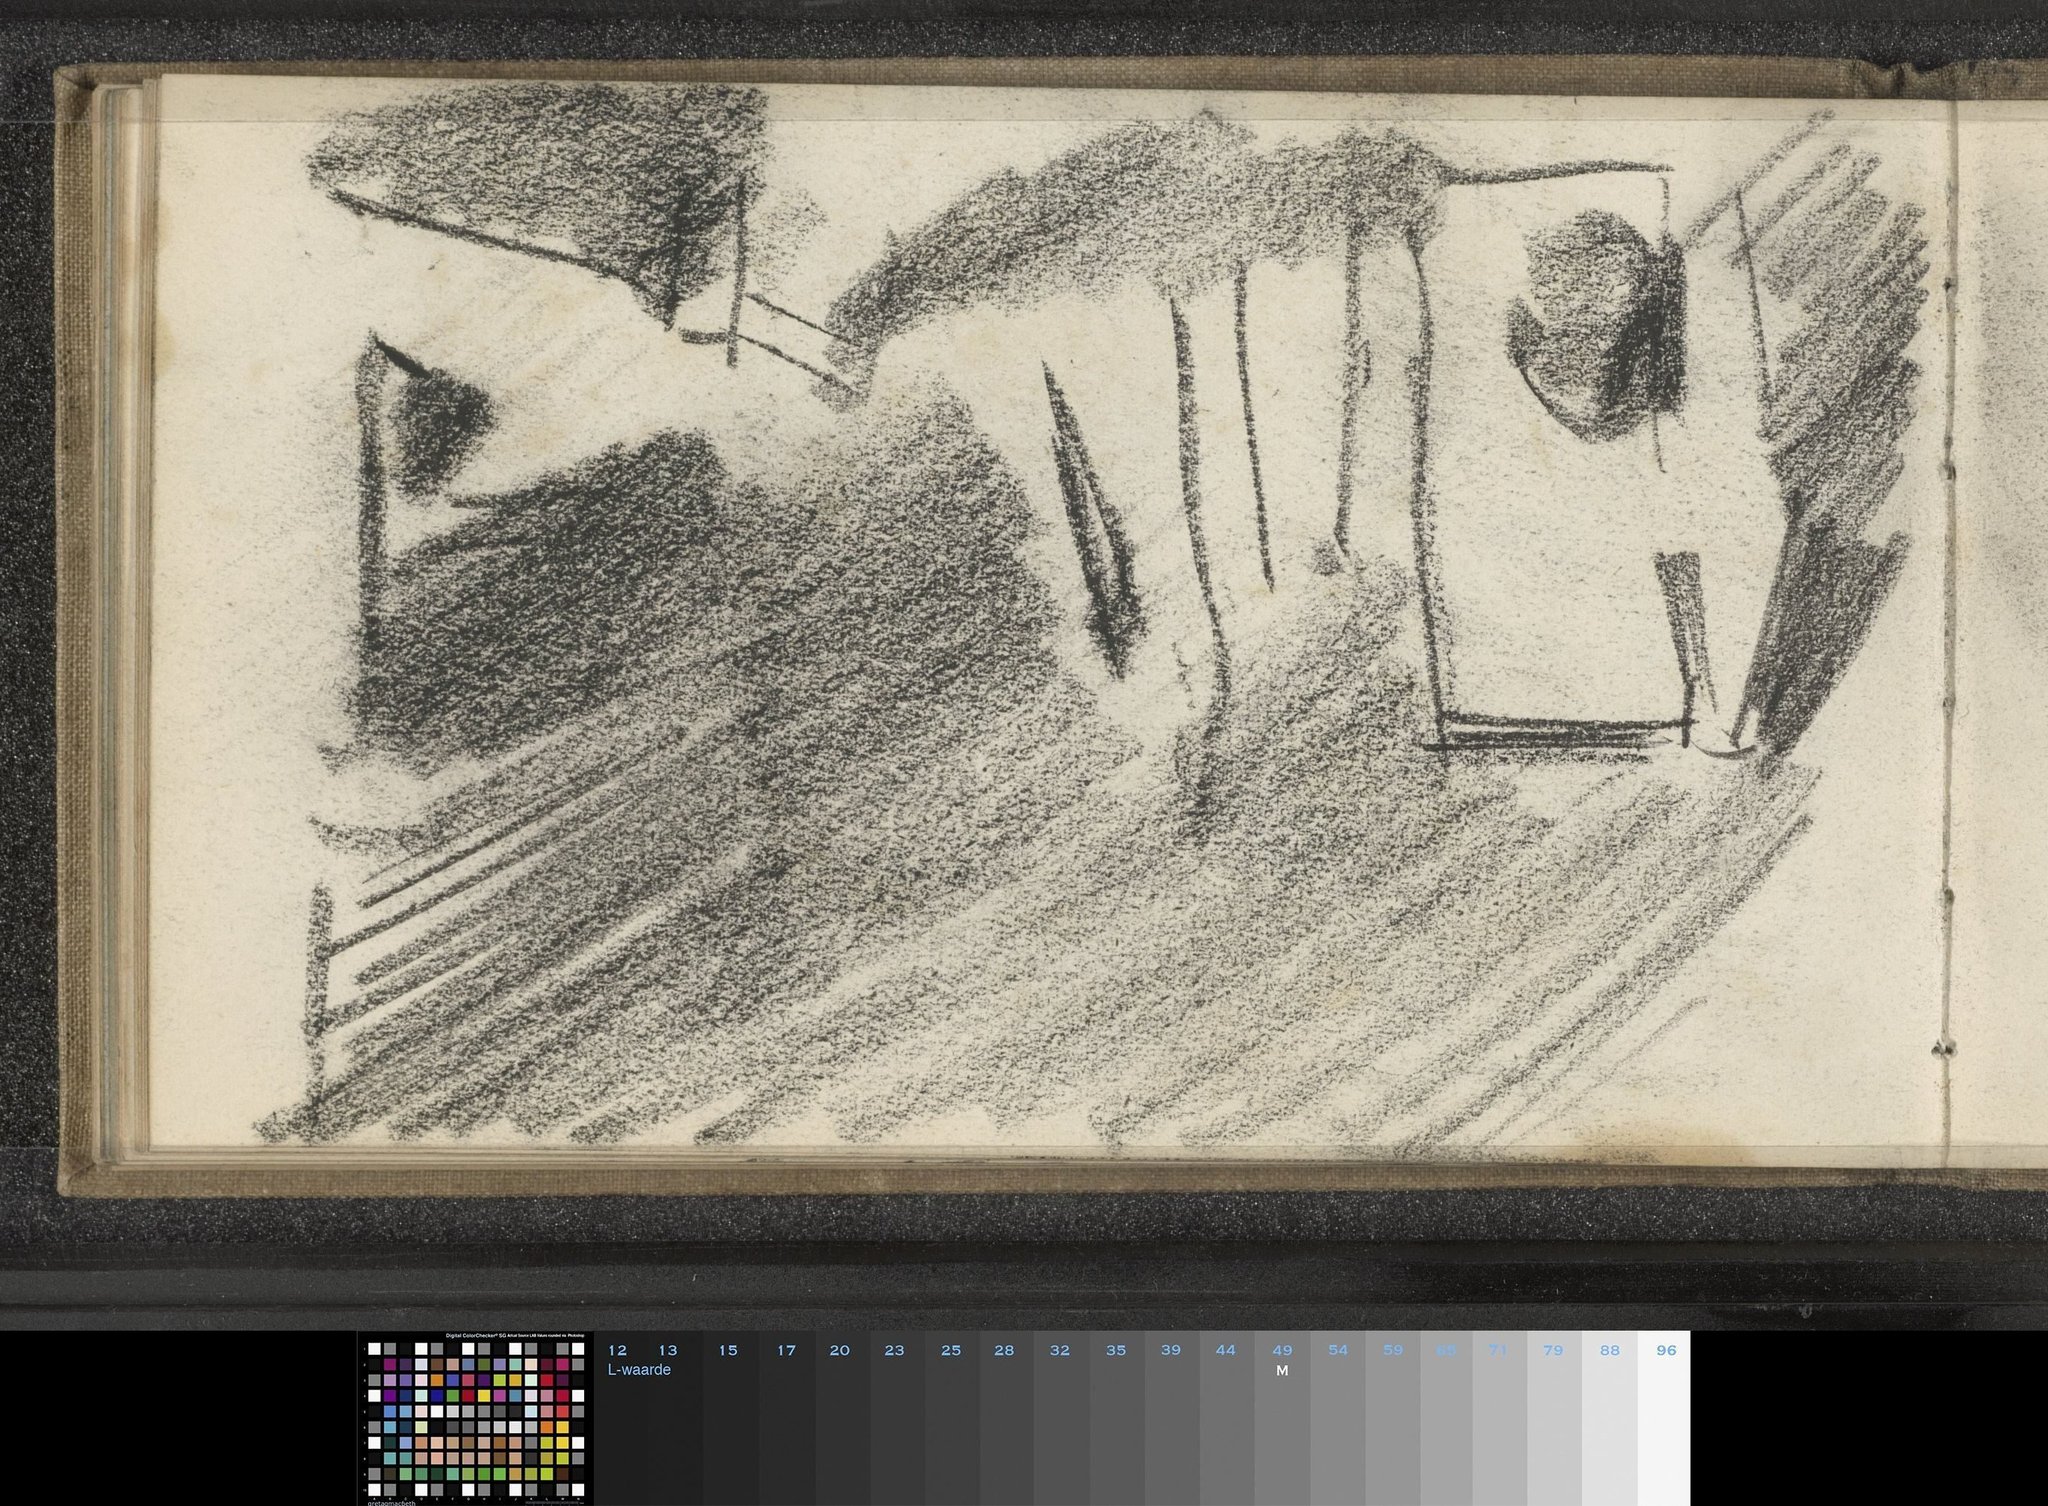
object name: sketchbook leaf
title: Studie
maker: george hendrik breitner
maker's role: draughtsman, painter, print maker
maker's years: 1857-1923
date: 1883-1885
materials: chalk, paper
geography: drenthe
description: Pagina 93 uit een schetsboek met 48 bladen.